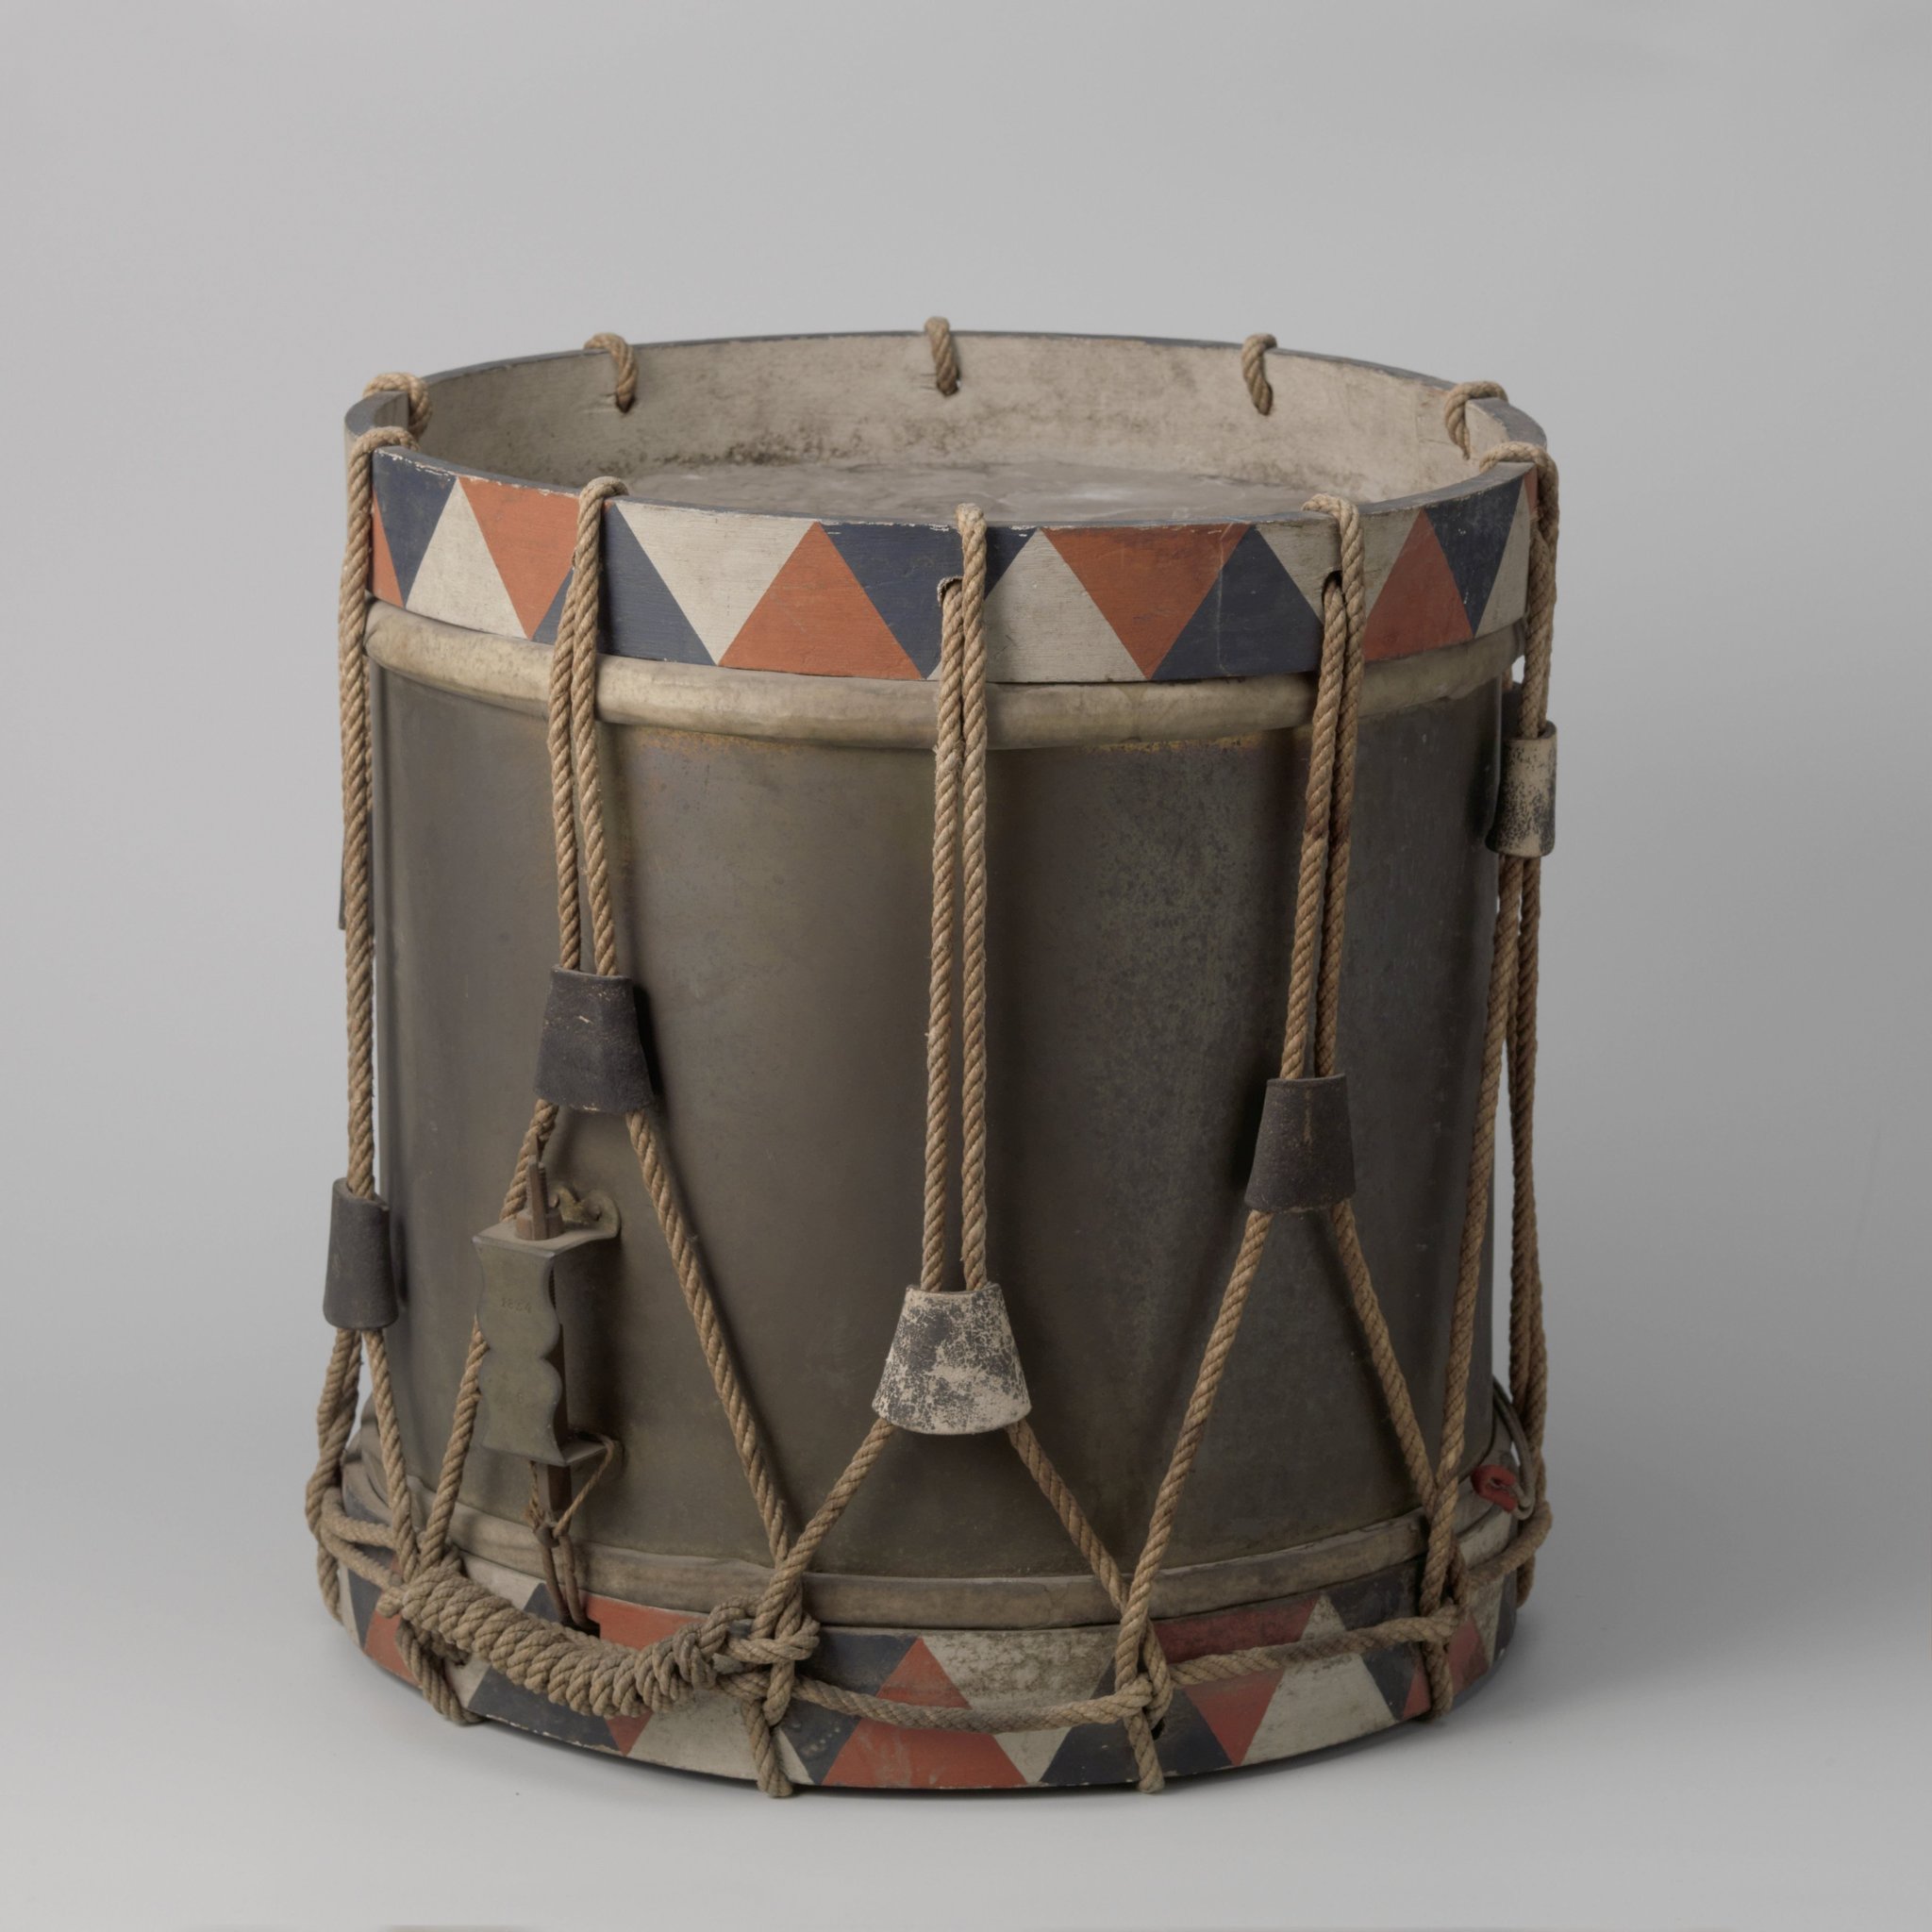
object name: musical instrument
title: Drum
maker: Anonymous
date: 1854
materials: brass, fiber, skin, wood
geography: netherlands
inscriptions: inscription: ‘1854-8’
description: Music has always been a crucial element of public celebrations, such as military parades, coronations, royal weddings, and funerals, adding grandeur to the solemnity of the occasion. Musical ensembles entrusted with performing music at these events have existed in Europe since the Middle Ages. This display highlights various marching bands and their musical instruments dating from the 16th to the 19th century.